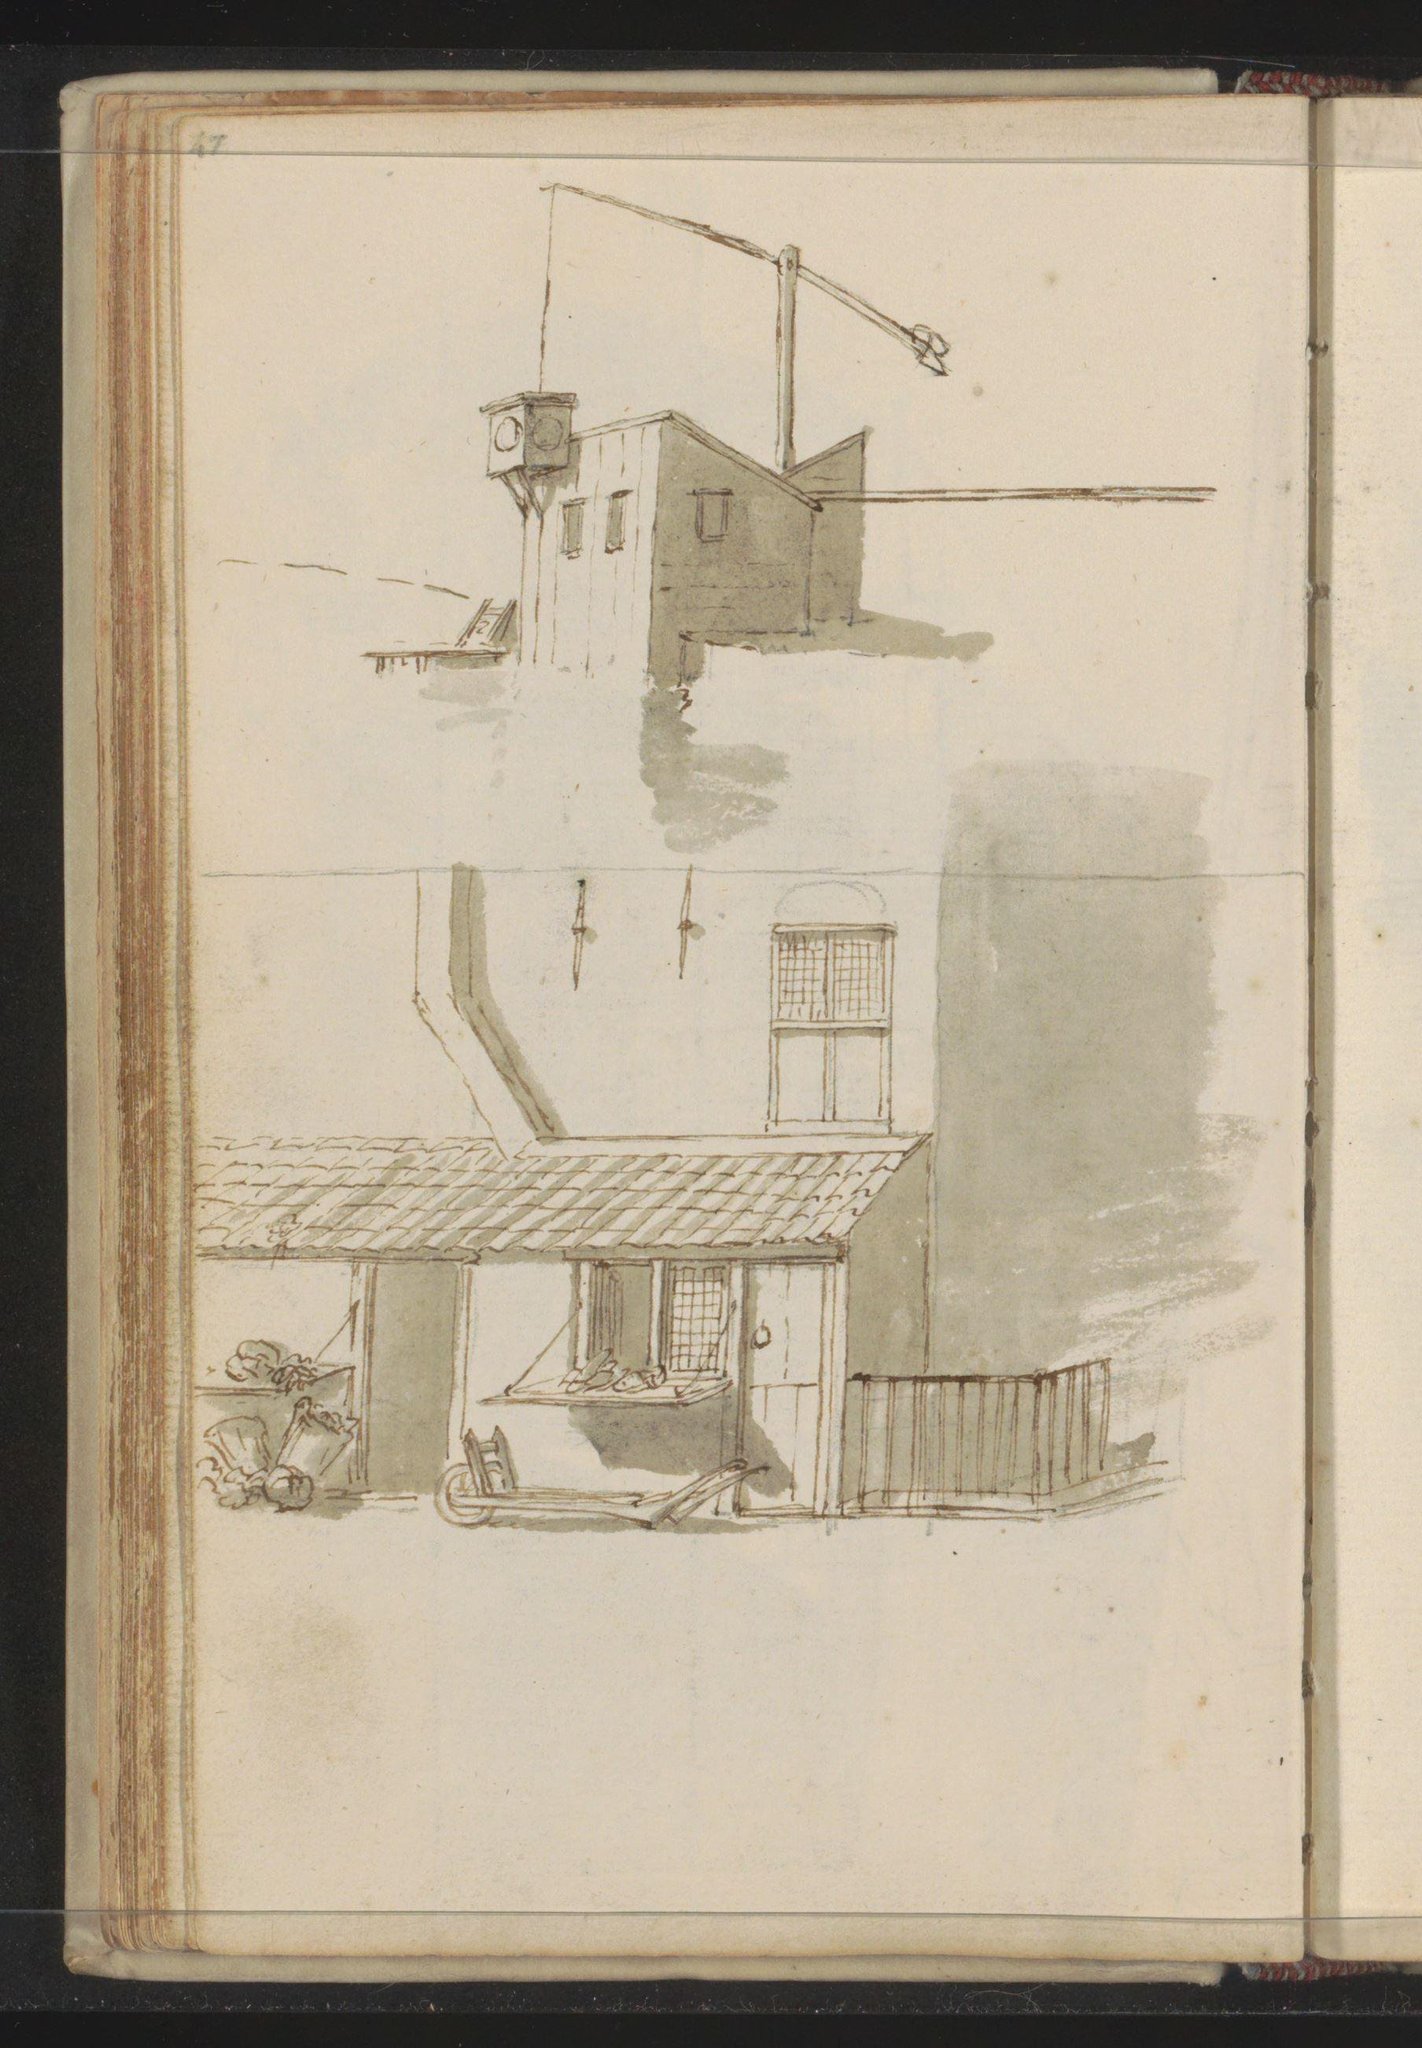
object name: sketchbook leaf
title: Winkels met uitgestalde waren in de etalages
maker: johannes huibert prins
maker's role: draughtsman, painter, print maker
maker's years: 1757-1806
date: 1783-1797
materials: ink, paper, pencil, watercolor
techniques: brush, pen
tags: locations for trading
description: Bij de ramen van de huizen is een plank uitgeklapt waarop etenswaren liggen. Tevens een studie van een dak waar vermoedelijk een hefboom op is gemonteerd. Pagina 47 uit een schetsboek met 175 pagina's.